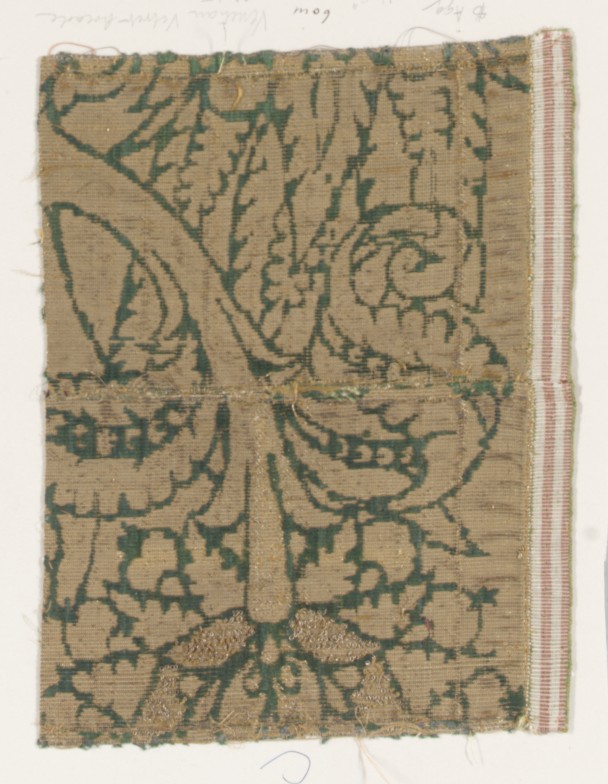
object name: fragment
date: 1500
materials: metal thread, silk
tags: leaves